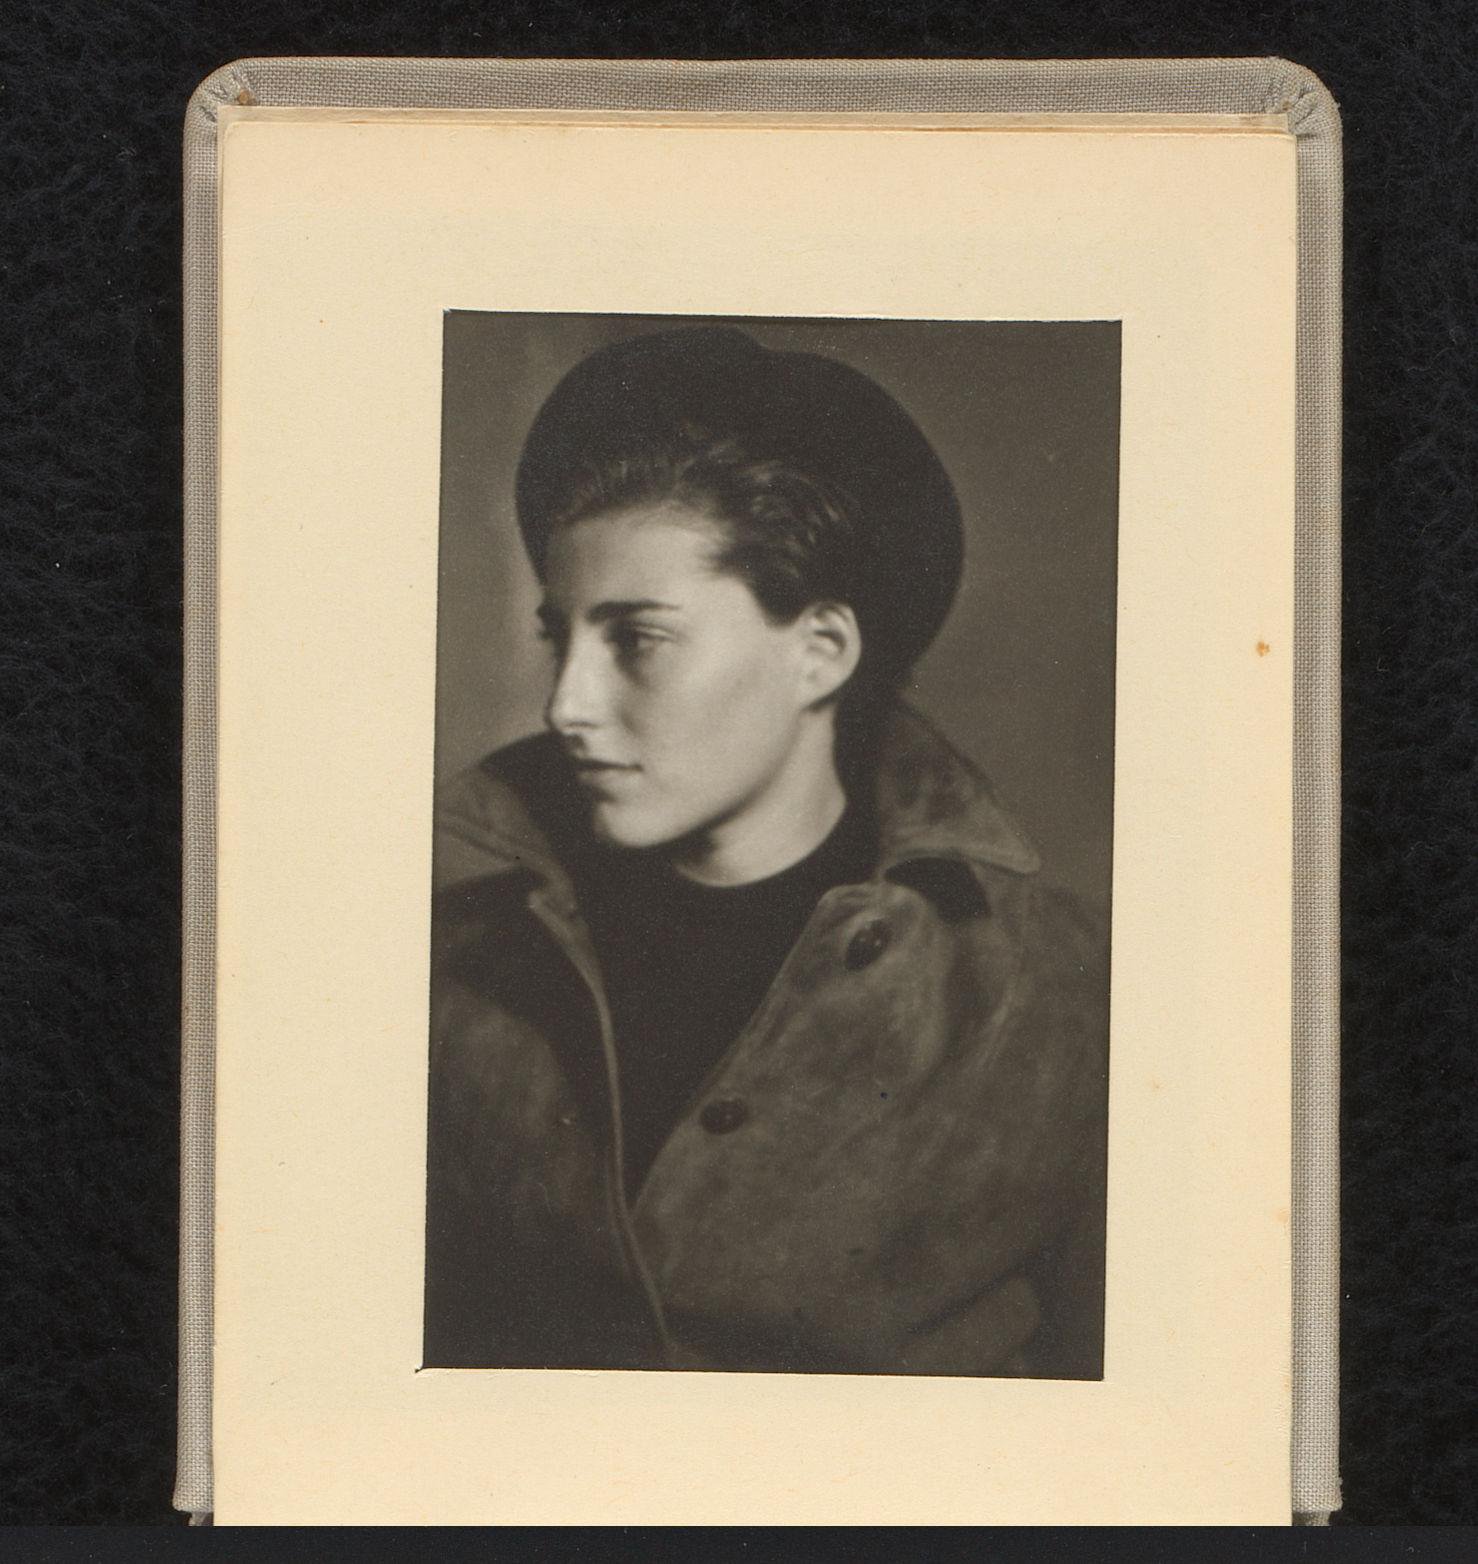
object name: photograph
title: Onbekende jonge vrouw, 1950-1965, Duitsland / Zwitserland / Israël / Verenigde Staten?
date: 1950-1965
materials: paper, photographic support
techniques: gelatin silver print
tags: historical persons not known by name - bb - woman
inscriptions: inscription: ‘Diese Bild hat den zweiten Preis gewonnen ... Aber jetzt habe ich schon wieder langere Haare’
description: Albumblad bevat een foto met portret van onbekende vrouw met kort haar. Onderdeel van het fotoalbum met diverse foto's van de jeugd van Isabel Wachenheimer voor en tijdens de oorlog en diverse momenten van haar volwassen leven na de Tweede Wereldoorlog.